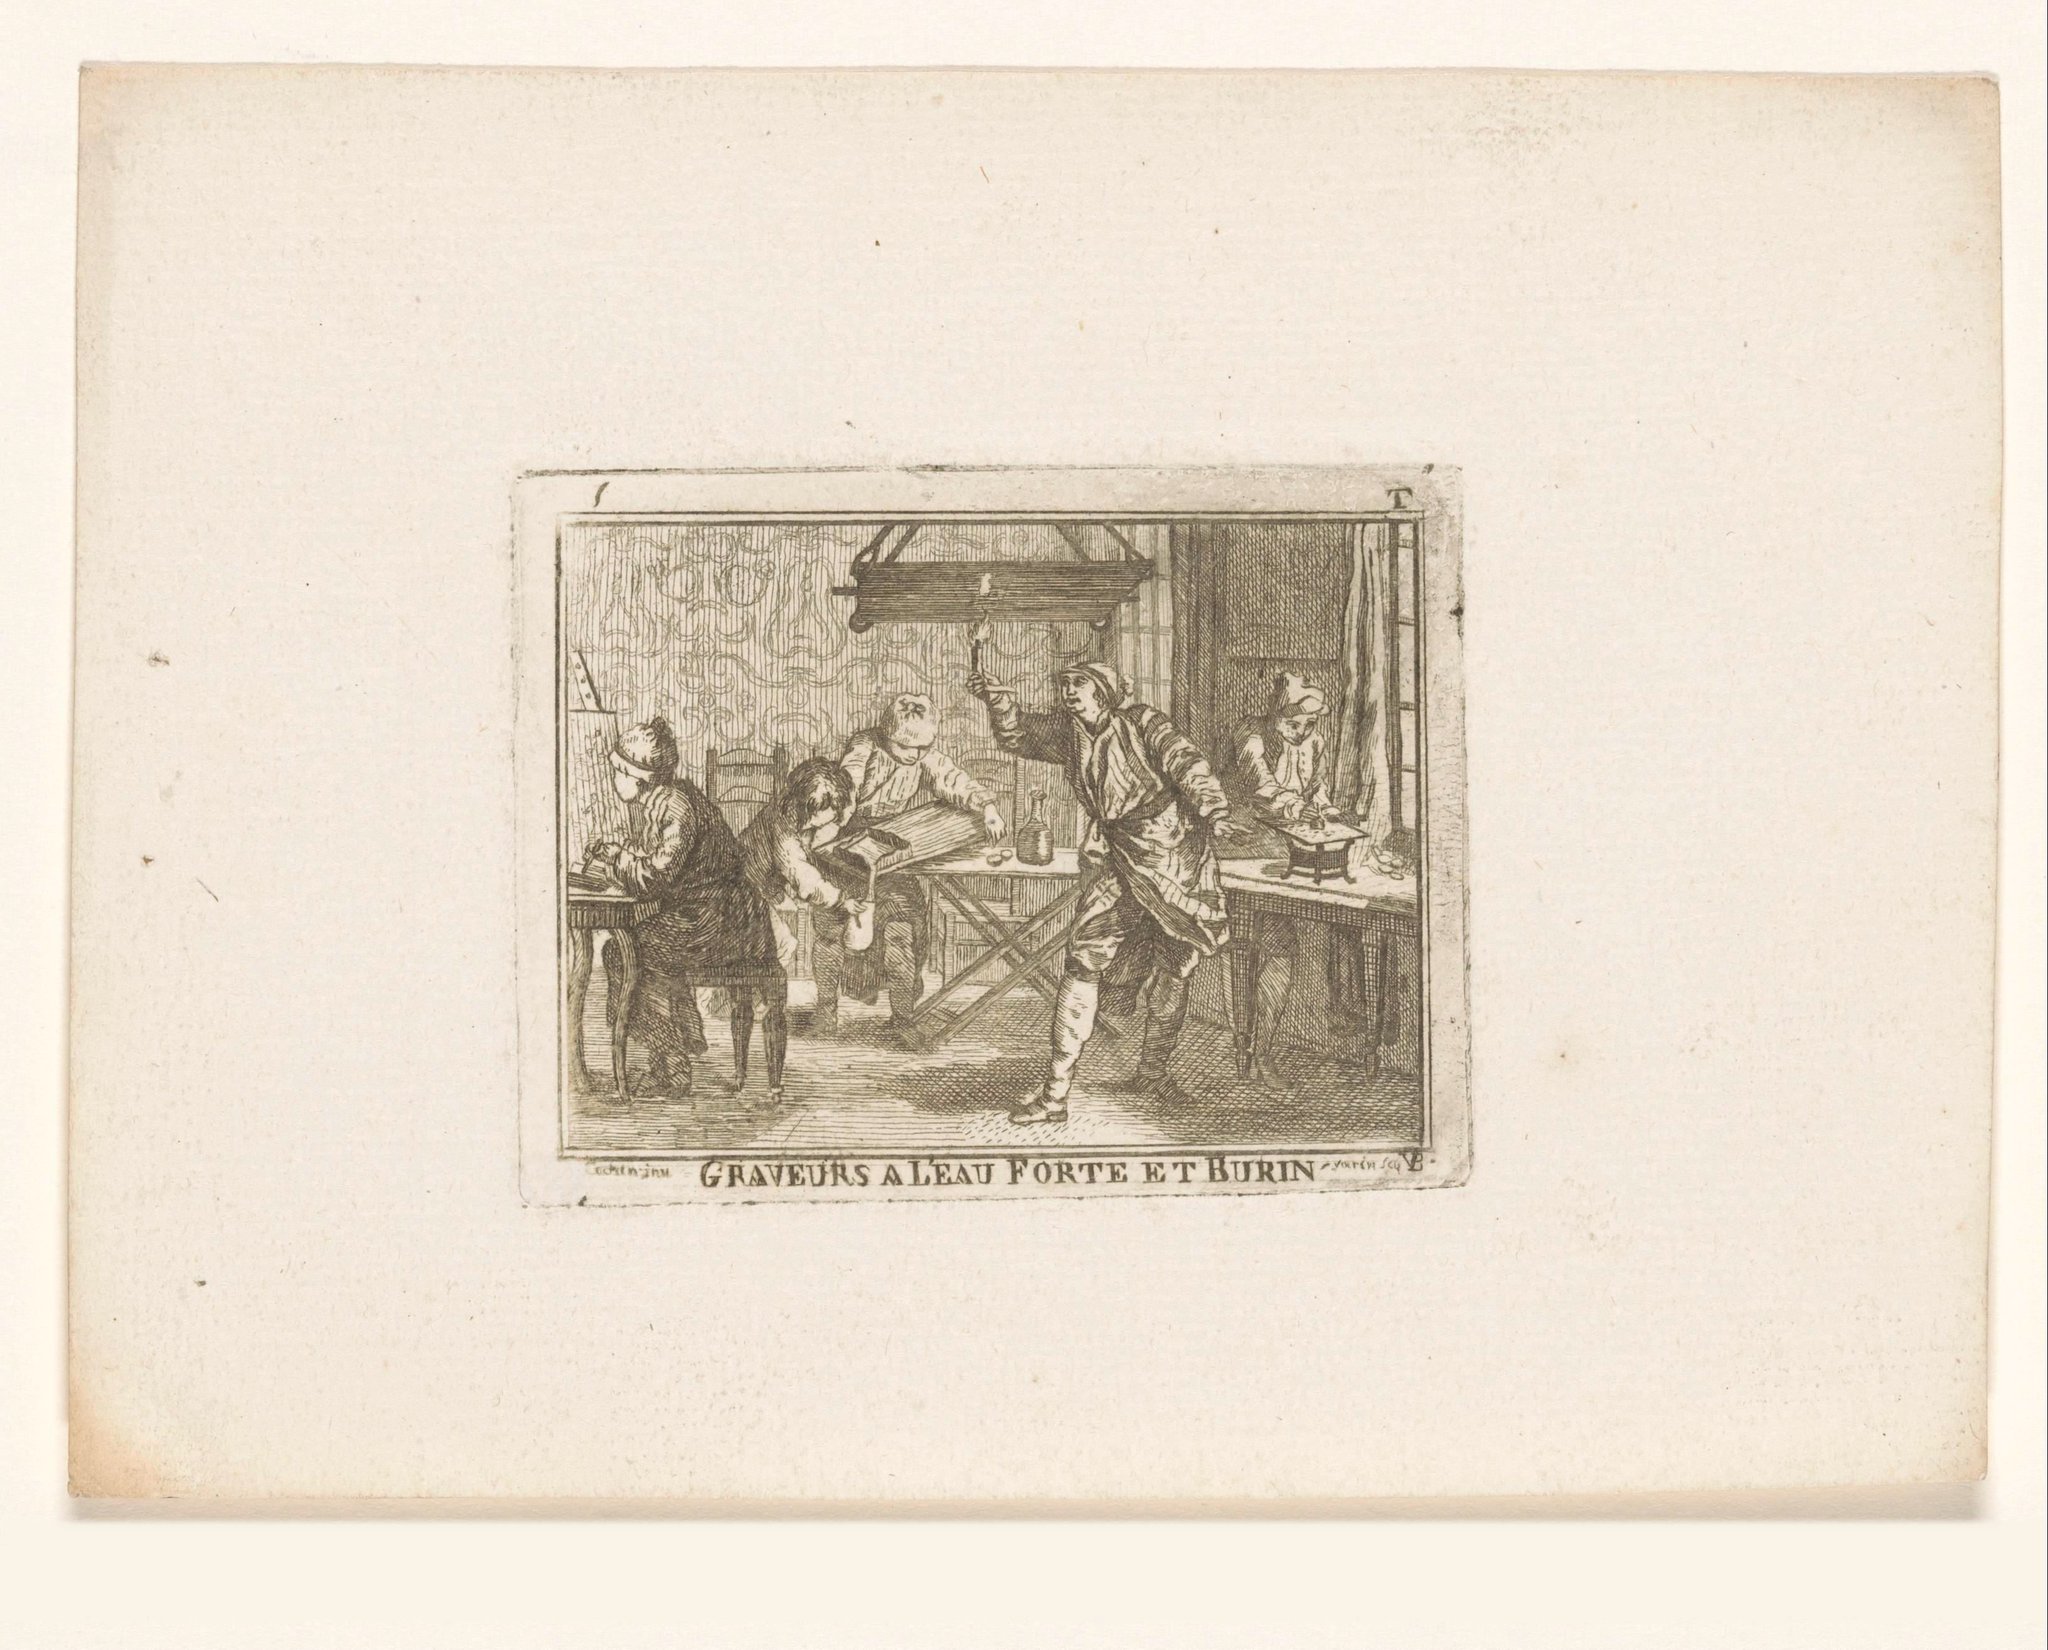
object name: print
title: Graveurs a l'eau forte et burin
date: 1745-1850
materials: paper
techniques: etching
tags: engraver, etcher, artist at work, in his workshop (+ graphic arts), tools, implements of graphic artist, workshop, studio of the artist (in general)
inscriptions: collector's mark: Lugt 2228, collector's mark: Lugt 4779, collector's mark: Lugt 4780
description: Een prentmaker achter een tafel, een man beroet een etsplaat die aan het plafond hangt met een kaars, een man giet een etsbad af in een kom die door een jongen wordt vastgehouden, een man achter een tafel voor het raam brengt een etsgrond aan. Rechtsboven de letter T.